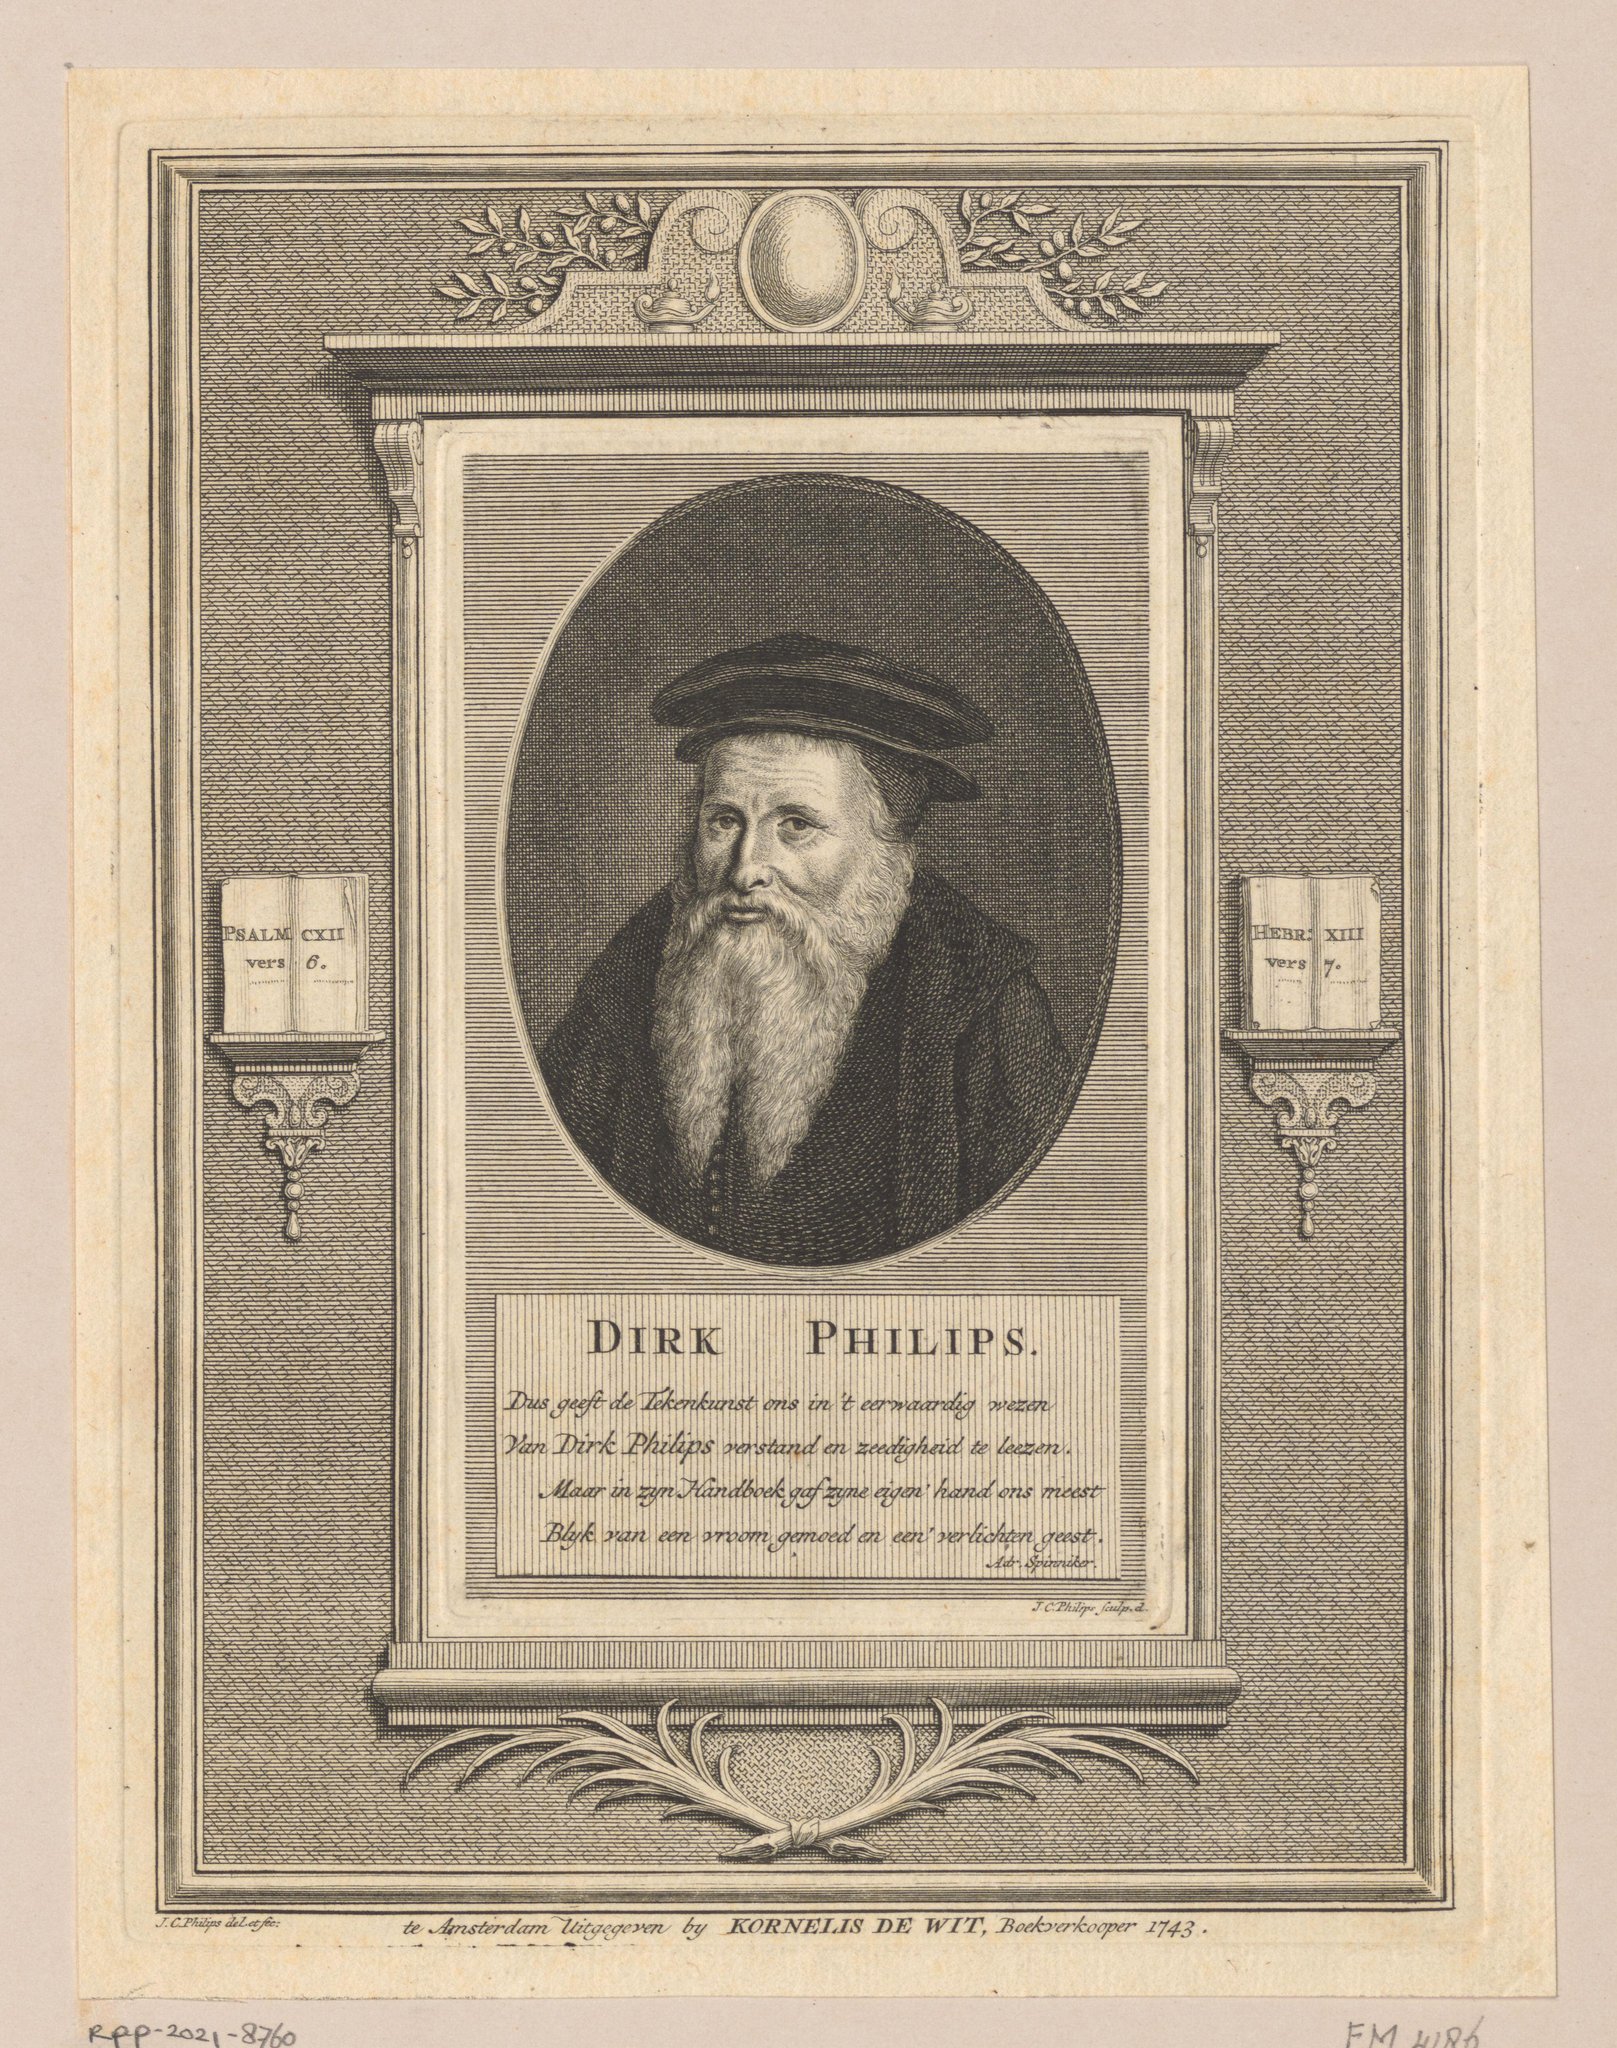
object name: print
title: Verzameling van afbeeldingen van mannen en leraren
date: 1743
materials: paper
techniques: engraving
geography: amsterdam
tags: adult man, historical persons, beard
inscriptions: date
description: Prent mogelijk uit: Verzaameling van de afbeeldingen van veele voornaame mannen en leeraaren, die (...) het leeraars ampt onder de doopsgezinde Christenen bediend hebben. Amsterdam: Kornelis de Wit, 1743.